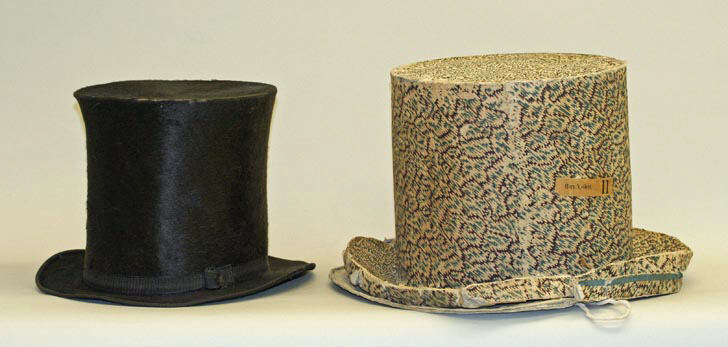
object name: hat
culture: american or european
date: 1828